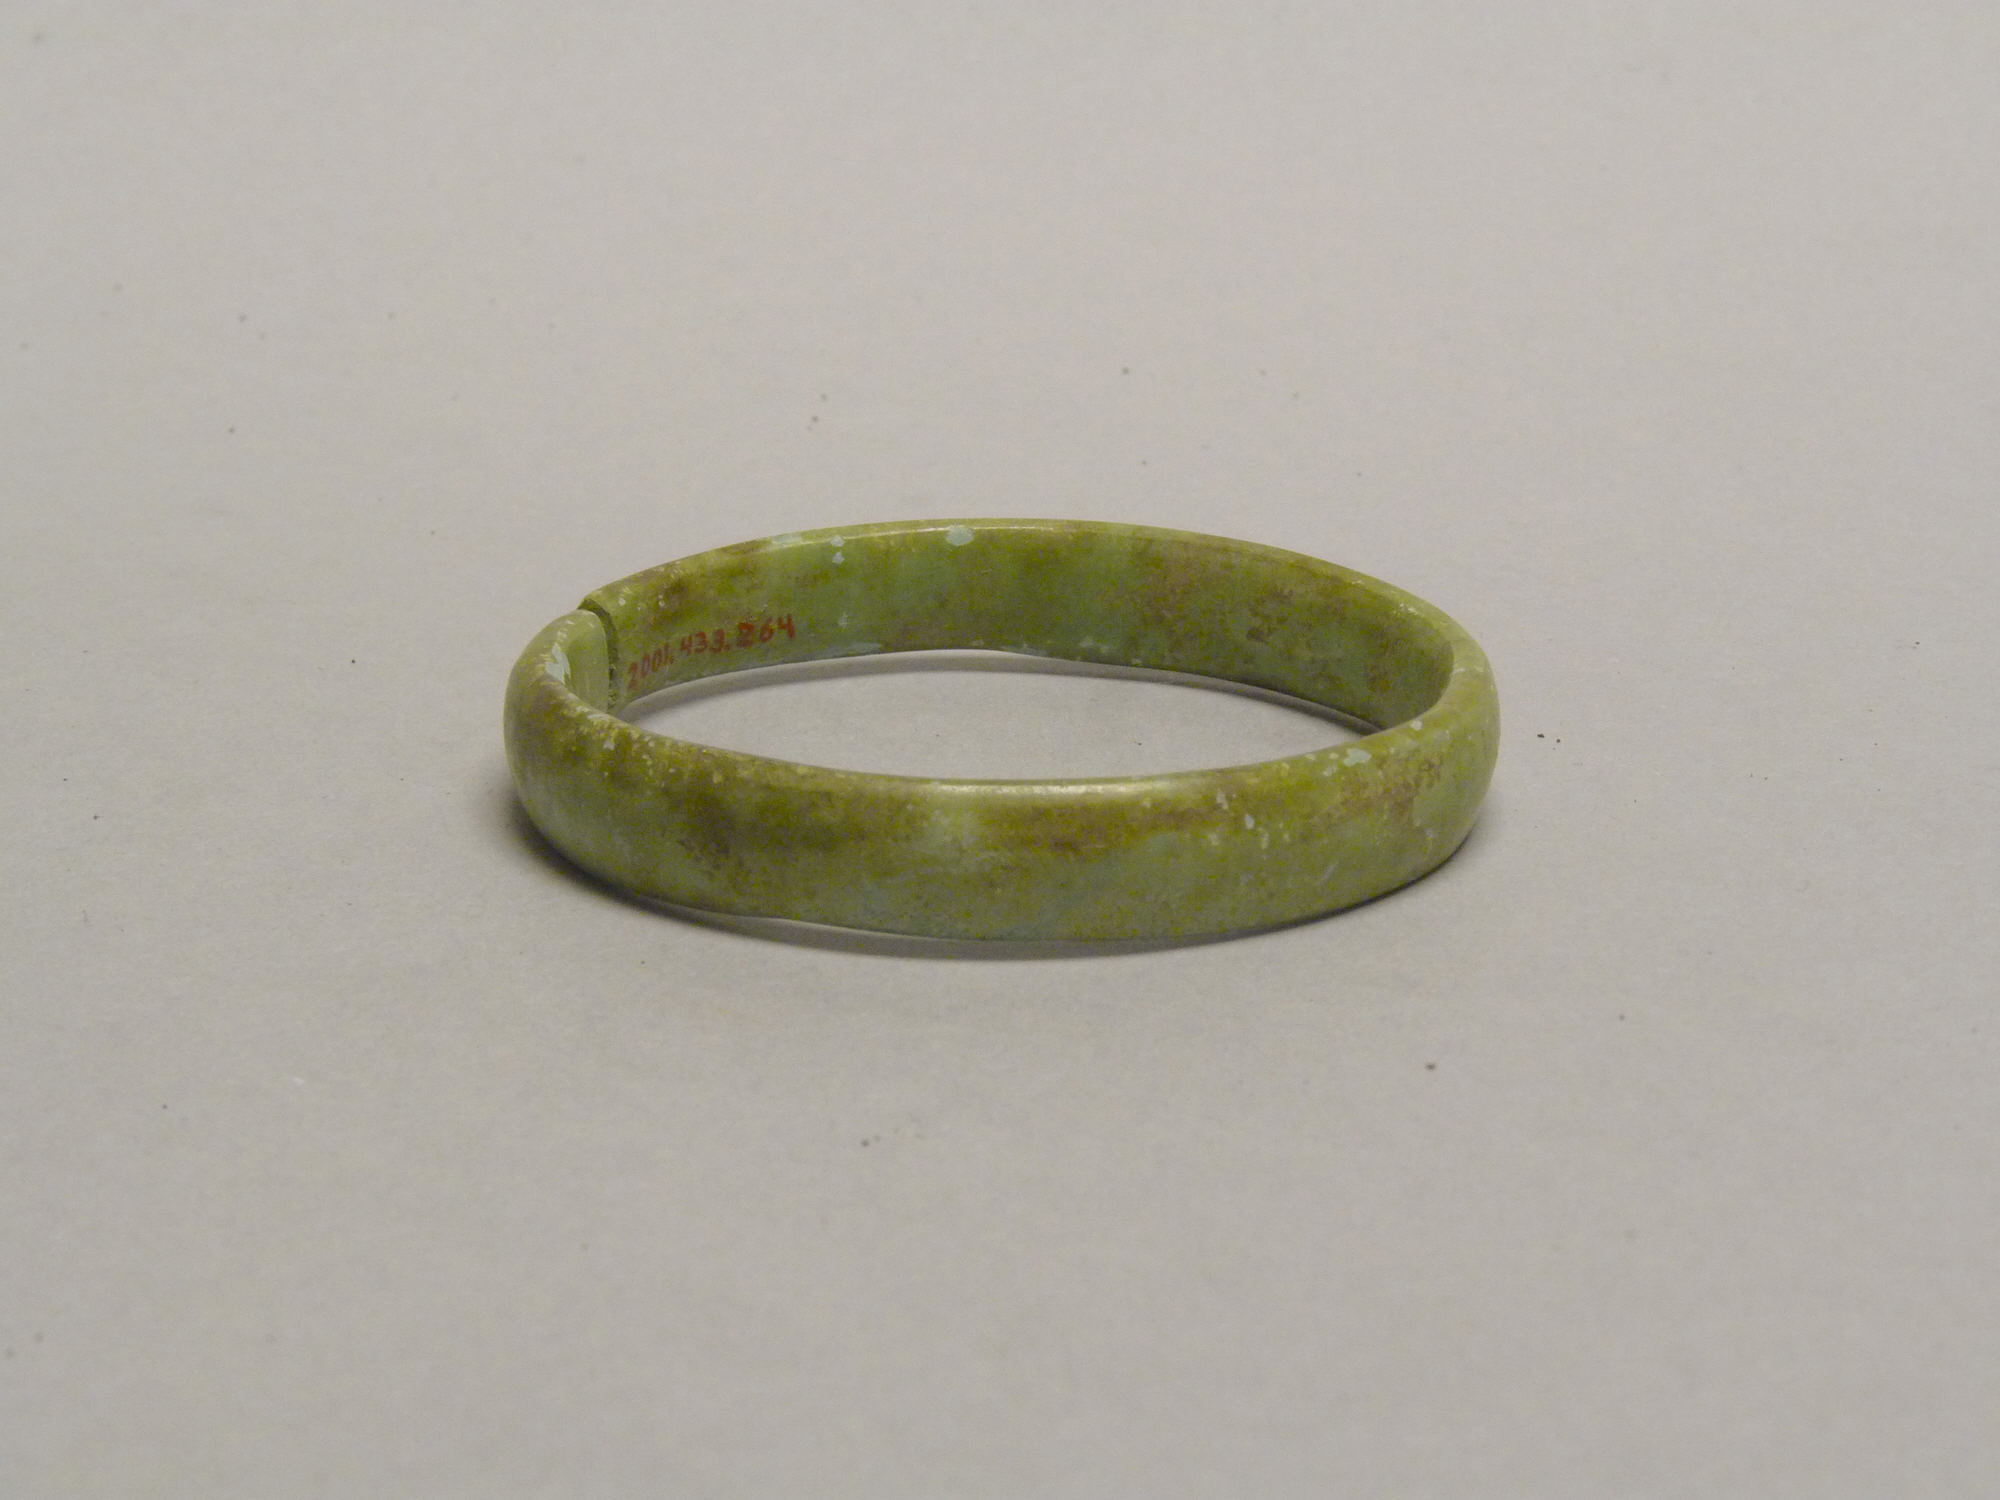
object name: bangle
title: Flat Bangle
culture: thai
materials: bronze